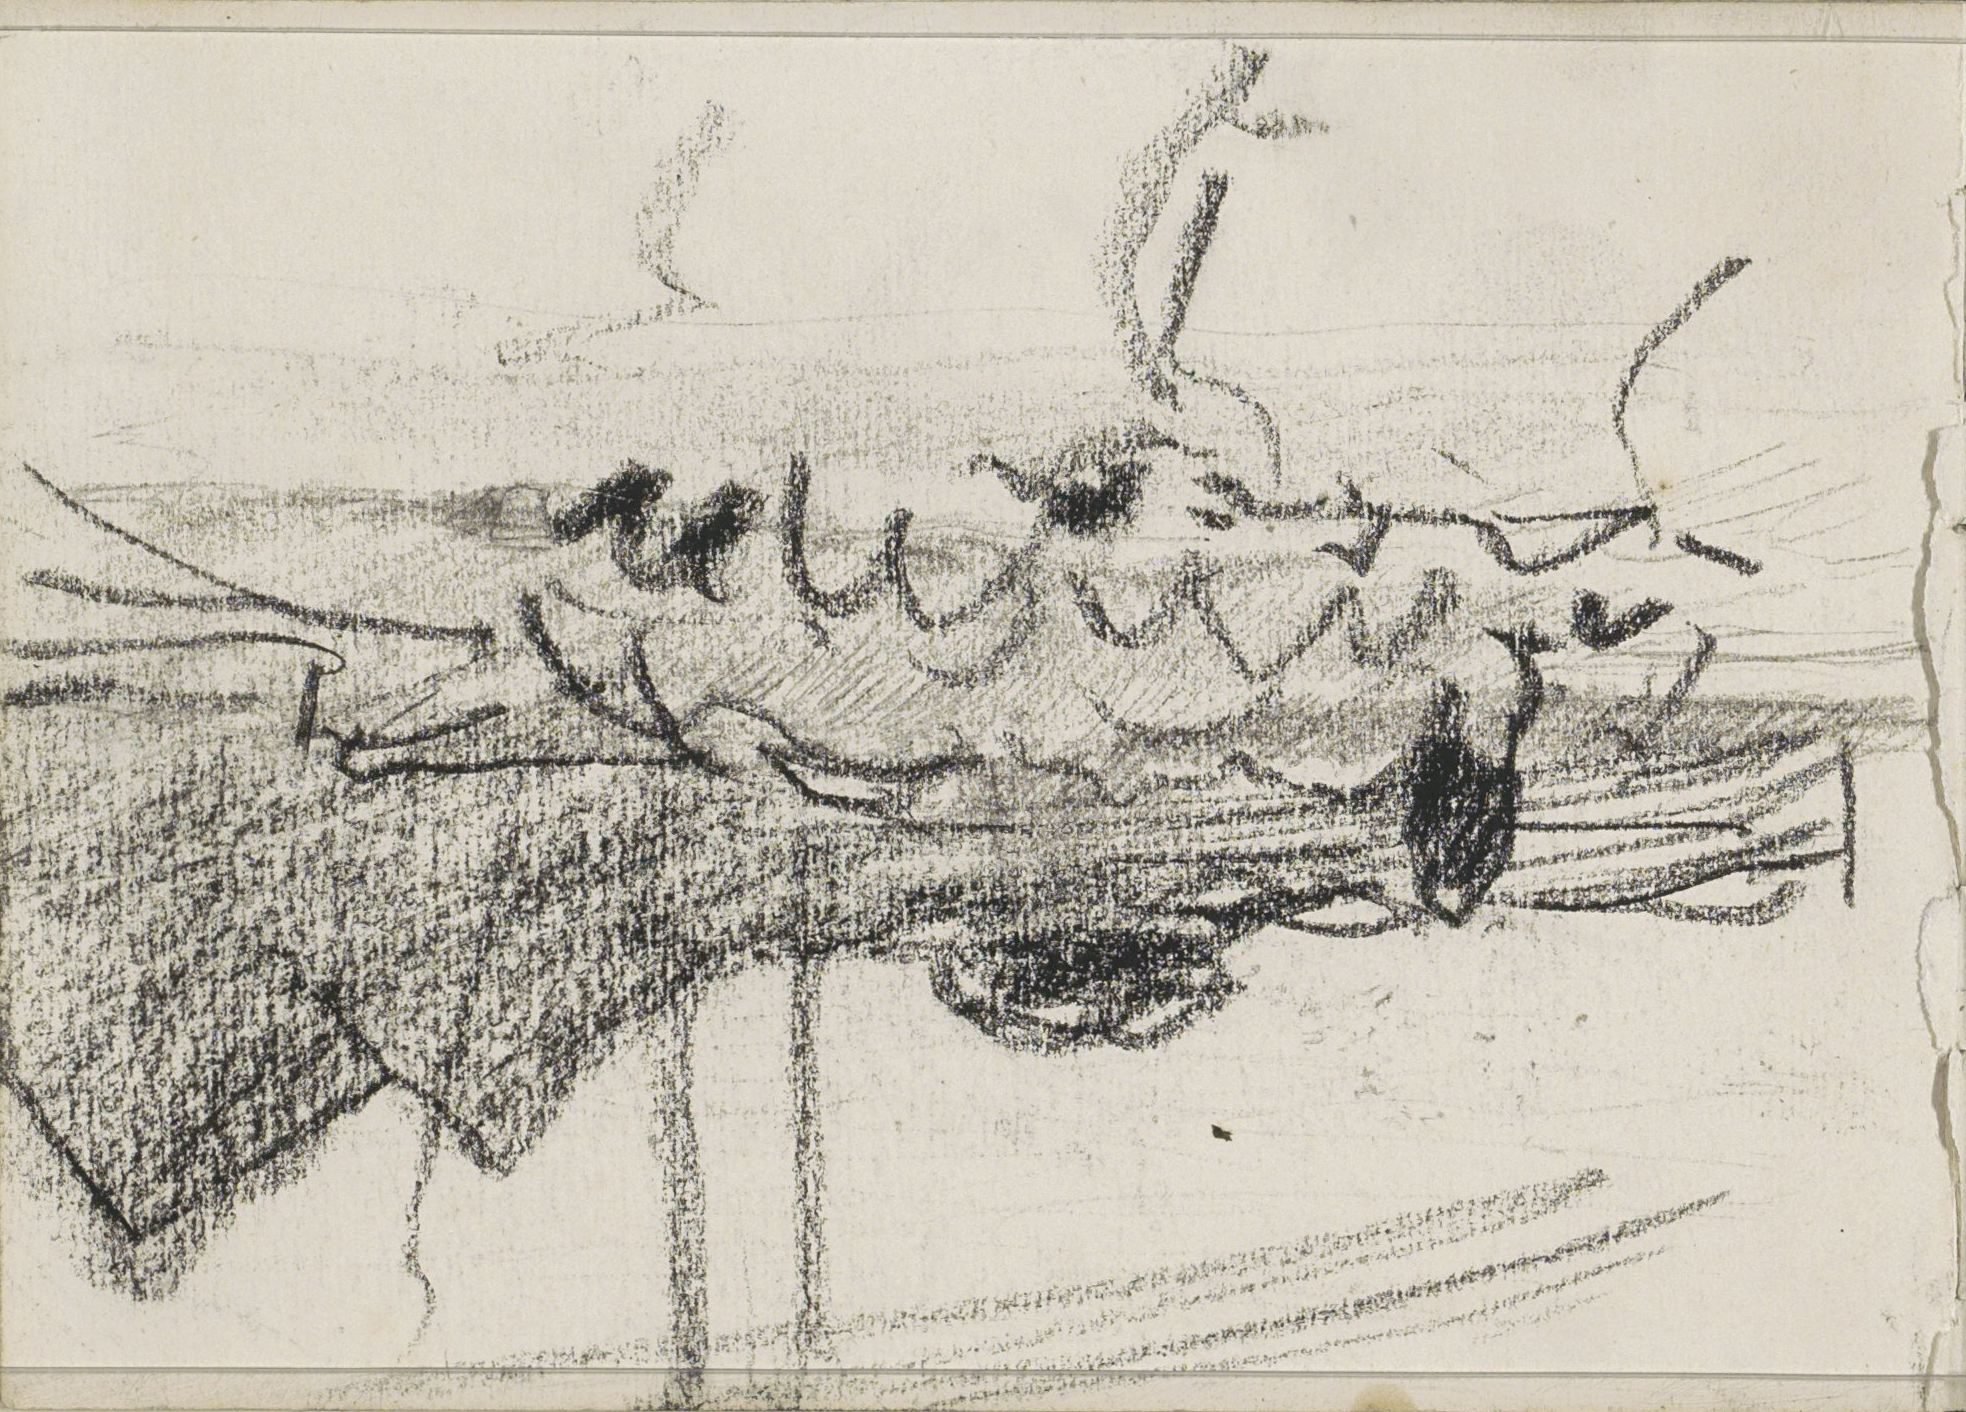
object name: sketchbook leaf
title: Herder met een schaapskudde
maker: anton mauve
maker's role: draughtsman, painter, print maker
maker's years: 1838-1888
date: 1848-1888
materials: chalk, paper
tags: herding, herdsman, herdswoman, shepherd, shepherdess, cowherd, etc., herd, flock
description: Blad 18 verso uit een schetsboek met 31 bladen.